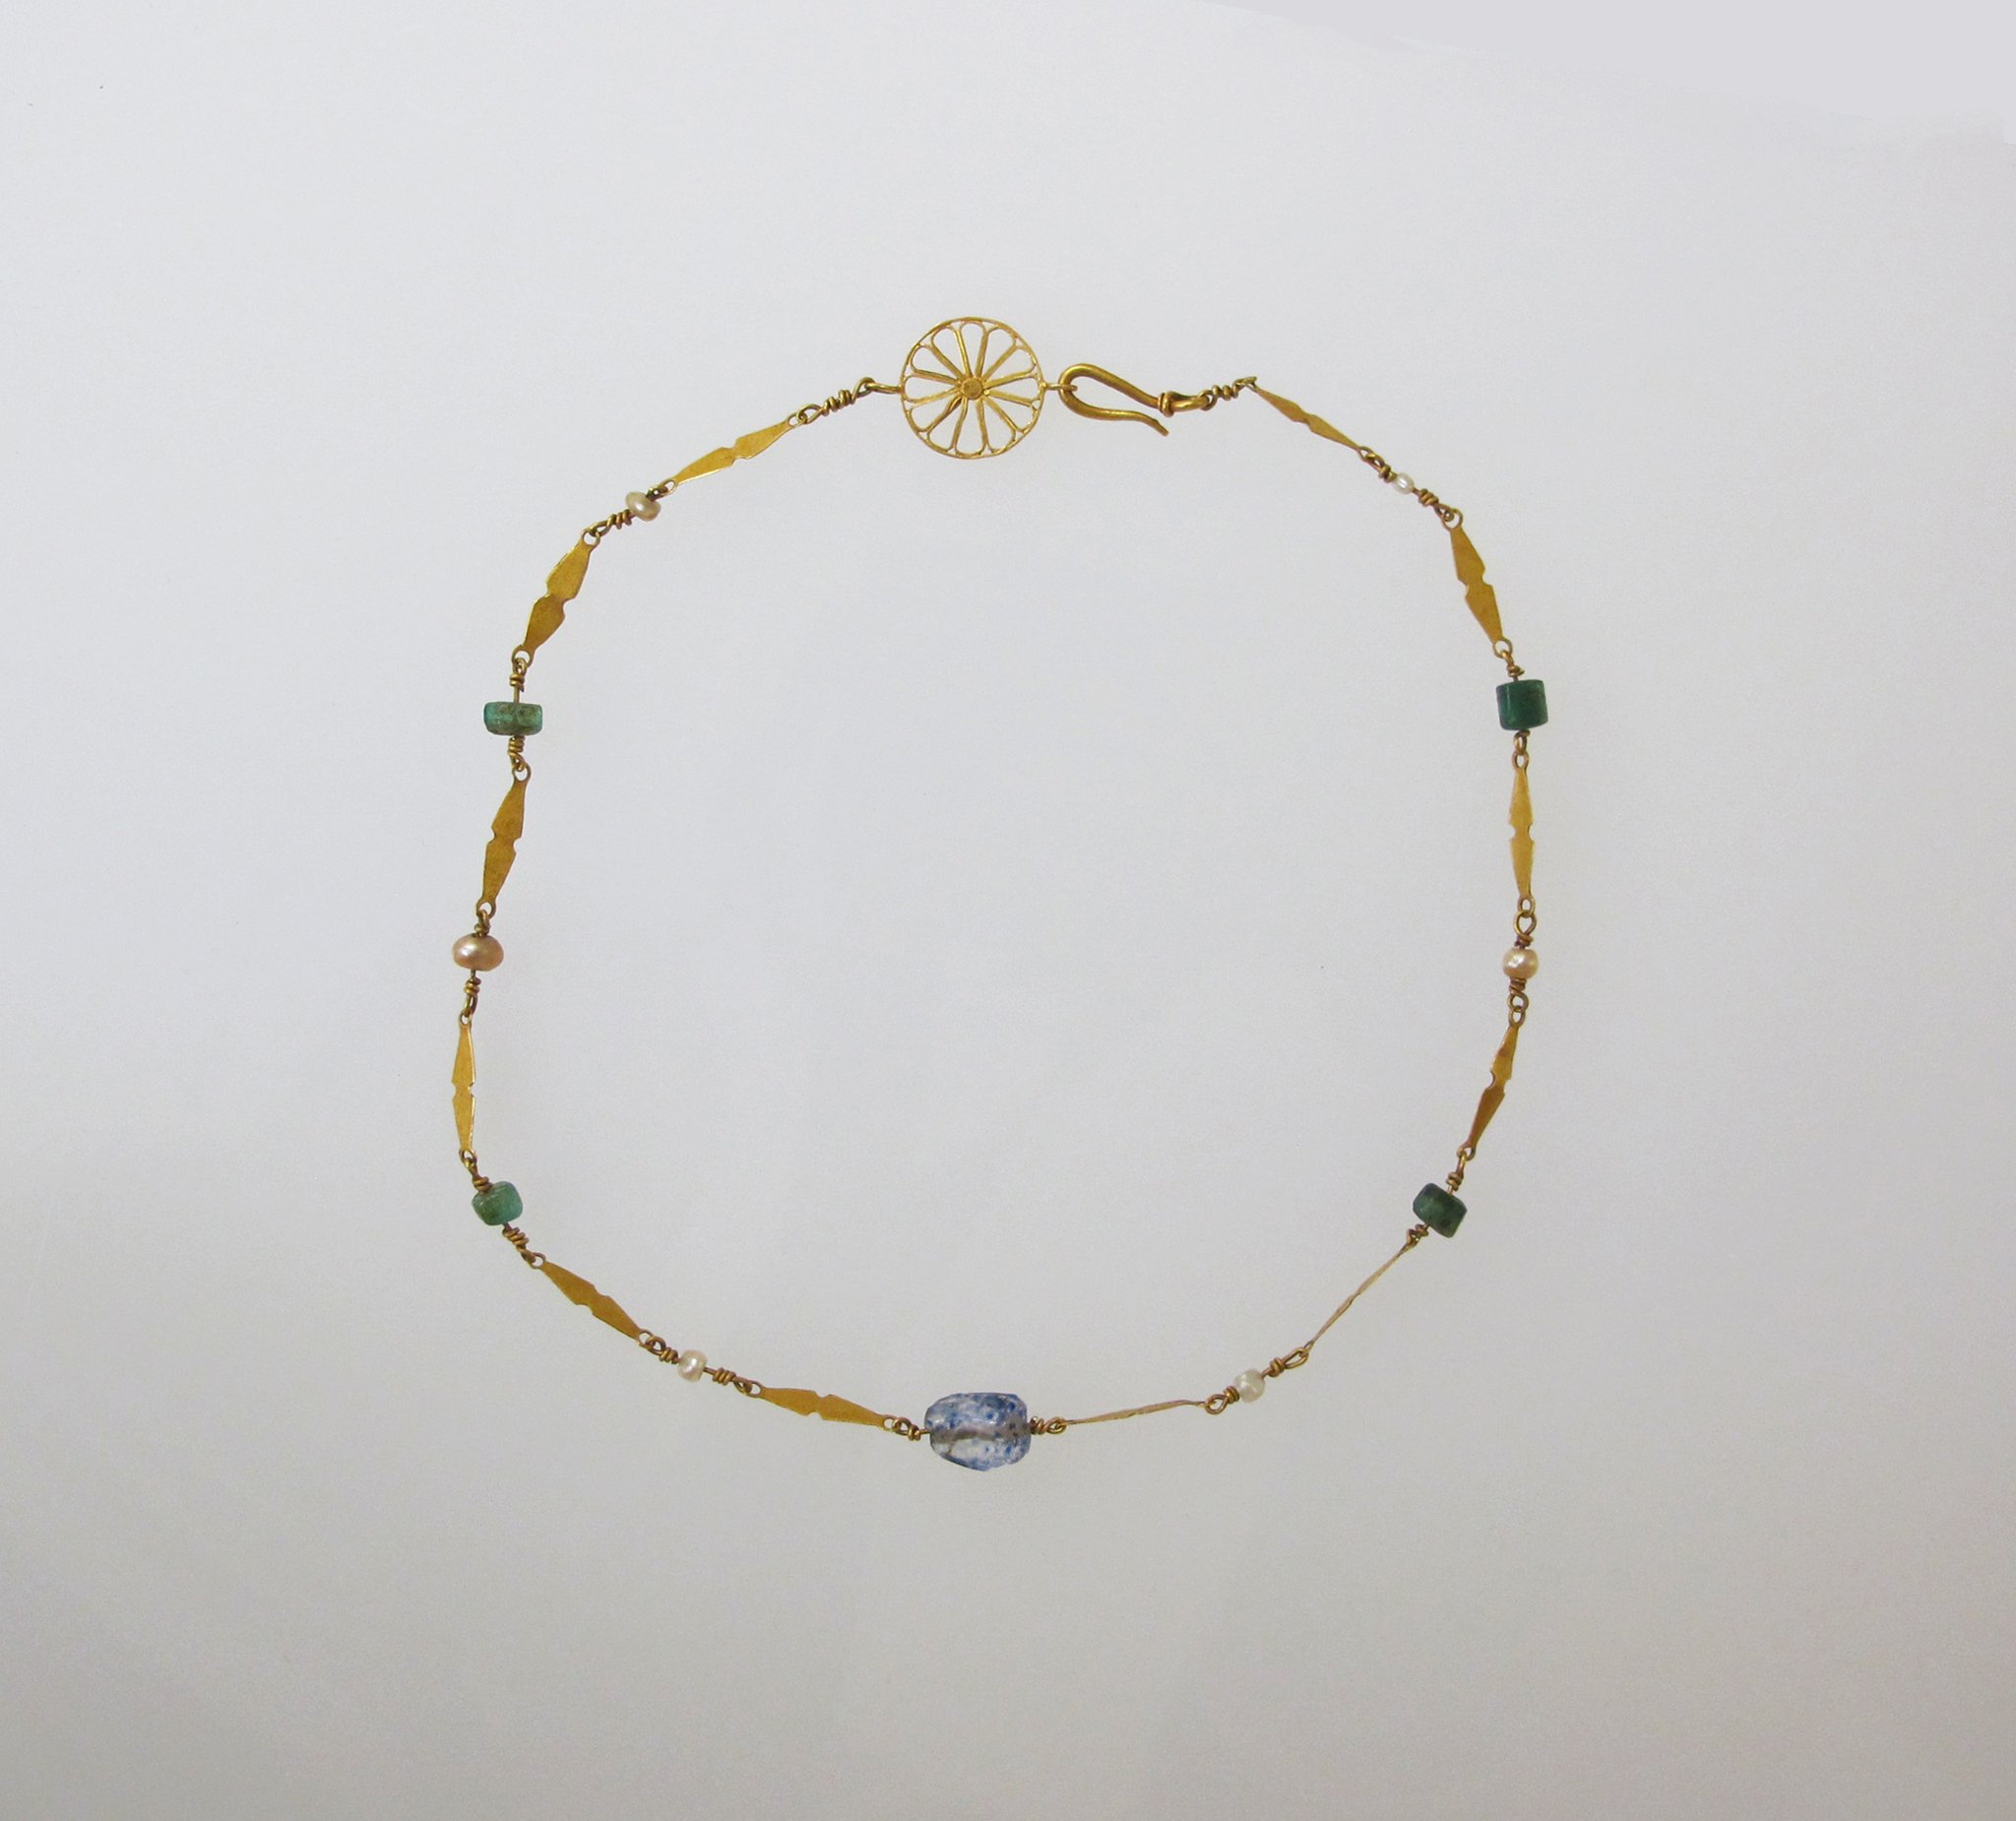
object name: necklace with pearl and beryl bead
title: Necklace with pearls and beryl beads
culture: roman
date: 1-200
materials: gold, pearl